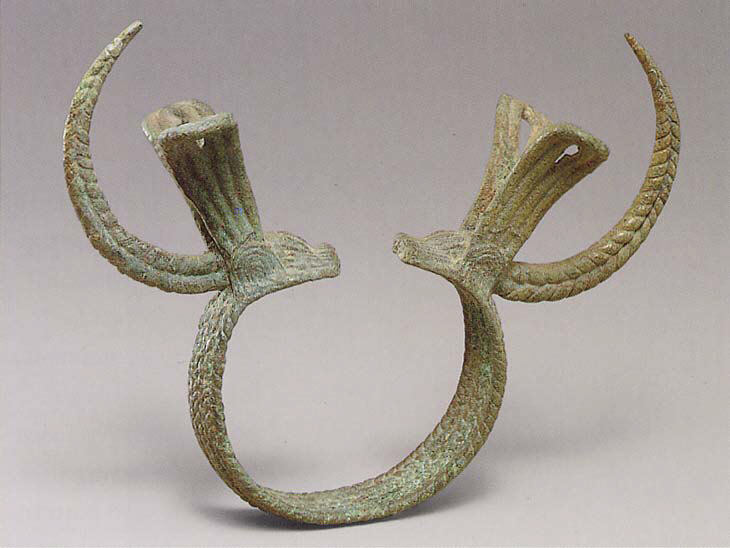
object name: bracelet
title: Bracelet with Dragonflies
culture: thai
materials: bronze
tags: dragonflies